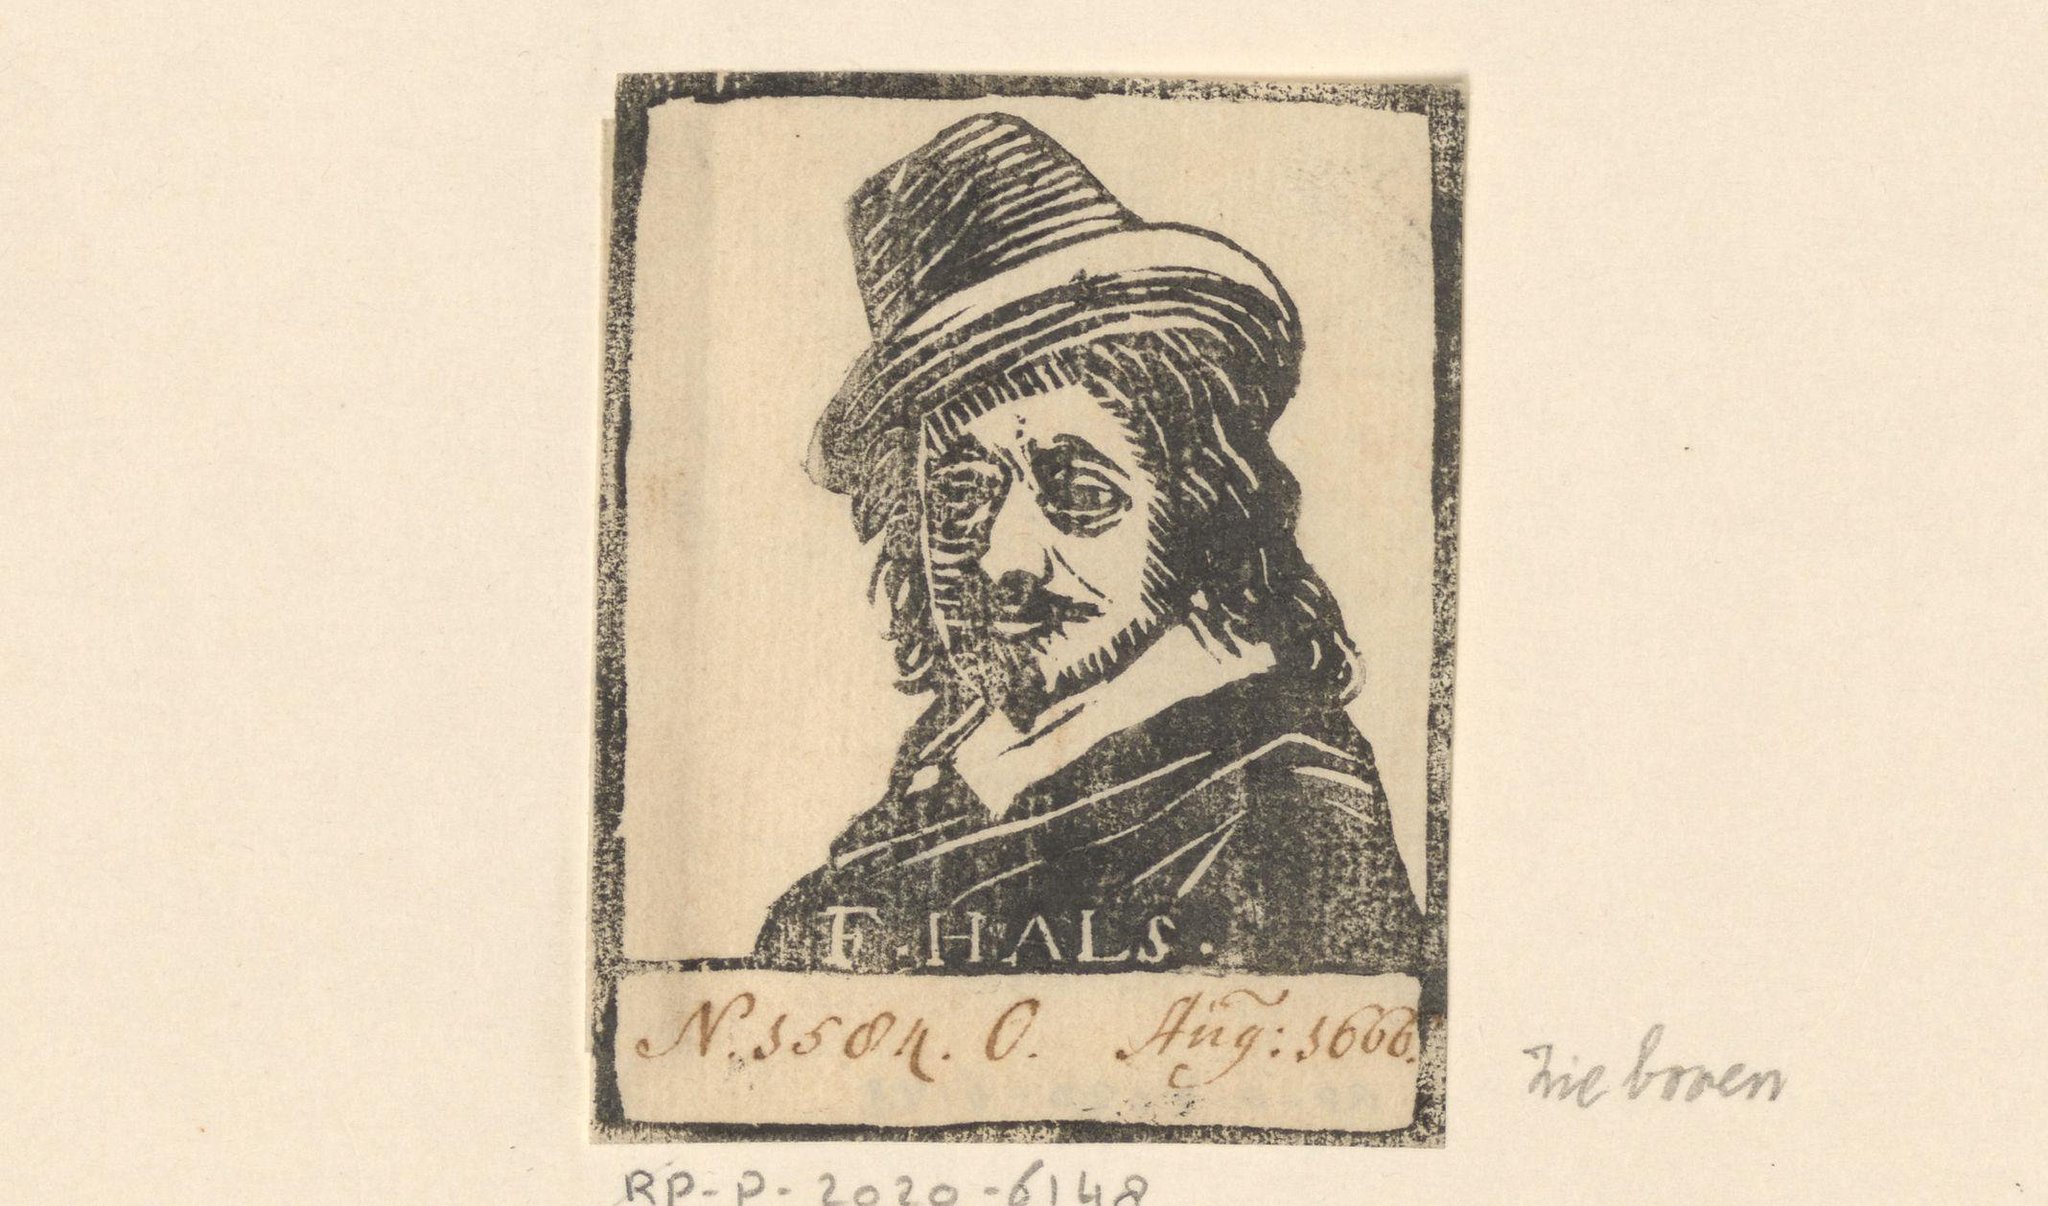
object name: print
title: Portret van Frans Hals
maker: Anonymous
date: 1650-1749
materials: paper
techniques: woodcut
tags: antwerp, draughtsman, frans hals, historical persons, portrait, self-portrait of painter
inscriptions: collector's mark: Lugt 2760, inscription: ‘N. 1584 O. Aug: 1666’, collector's mark: Lugt 2166